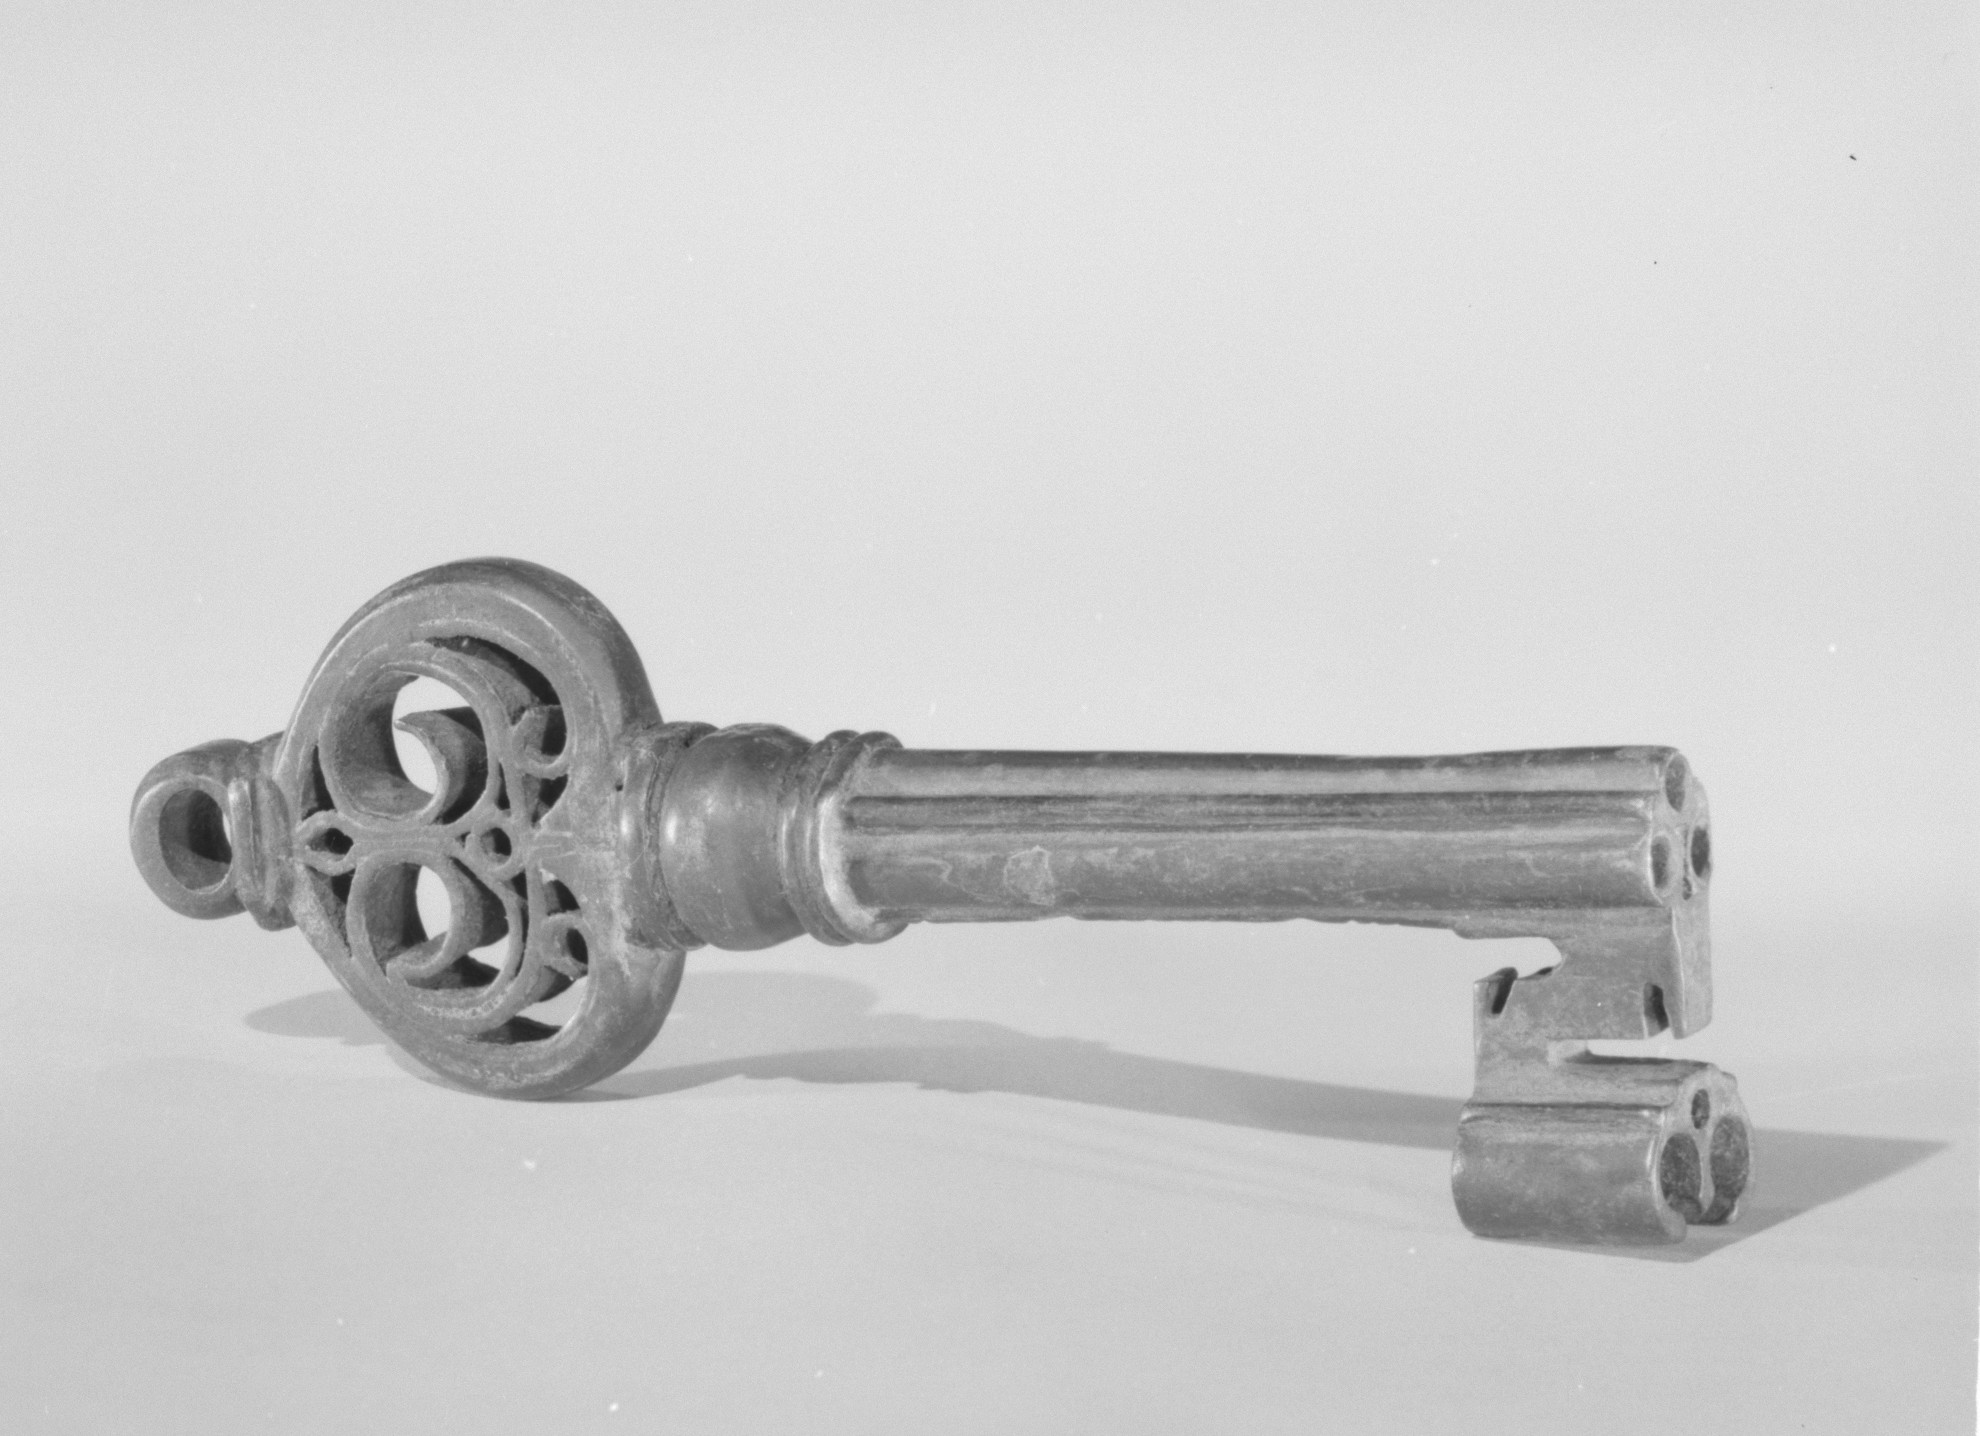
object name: coffer or chest key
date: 1601-1700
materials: iron